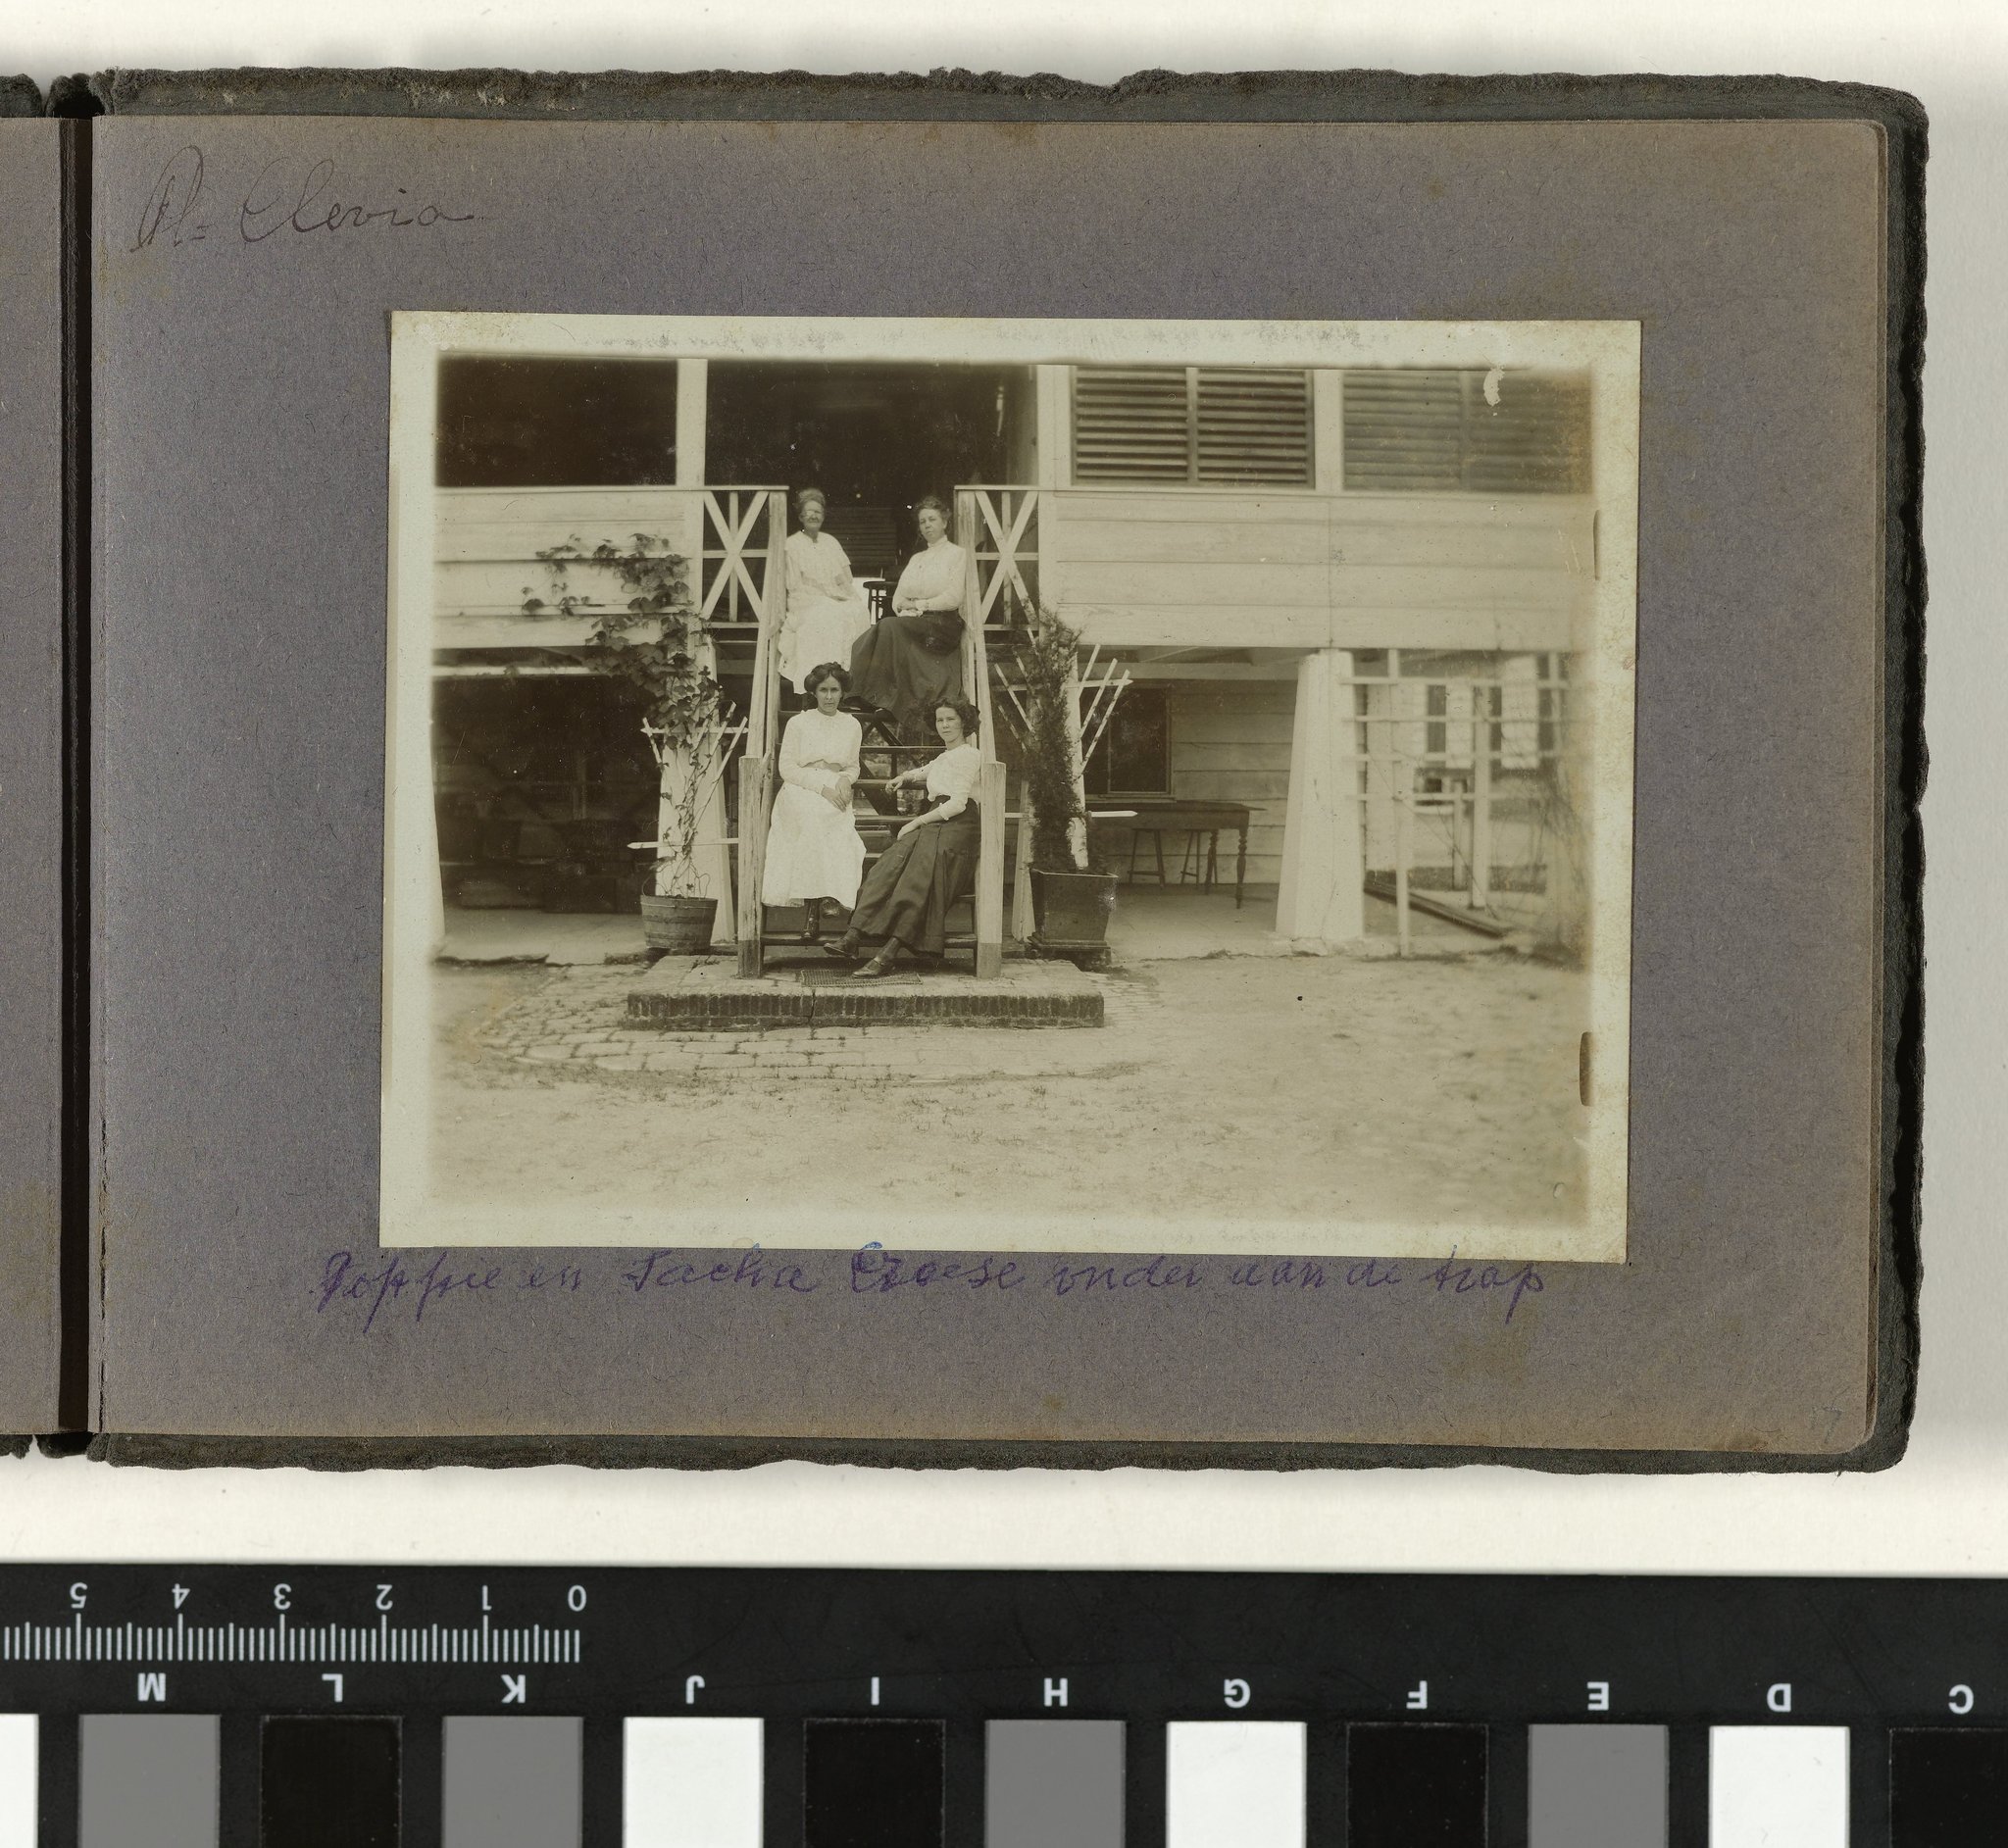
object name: photograph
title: Maria Gonggrijp met vriendinnen op de trap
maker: Anonymous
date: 1910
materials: photographic support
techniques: gelatin silver print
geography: suriname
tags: plantation, suriname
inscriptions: inscription: ‘Pl. Clevia / Poppie en Sacha Croese onder aan de trap’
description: Vier vrouwen zittend op de trap van het plantagehuis op Clevia. Onderaan Maria Gonggrijp met Sacha Croese, bovenaan twee oudere vrouwen. Onderdeel van het fotoalbum over de familie Gonggrijp op de plantages Clevia en Morgenstond in Suriname rond 1910.